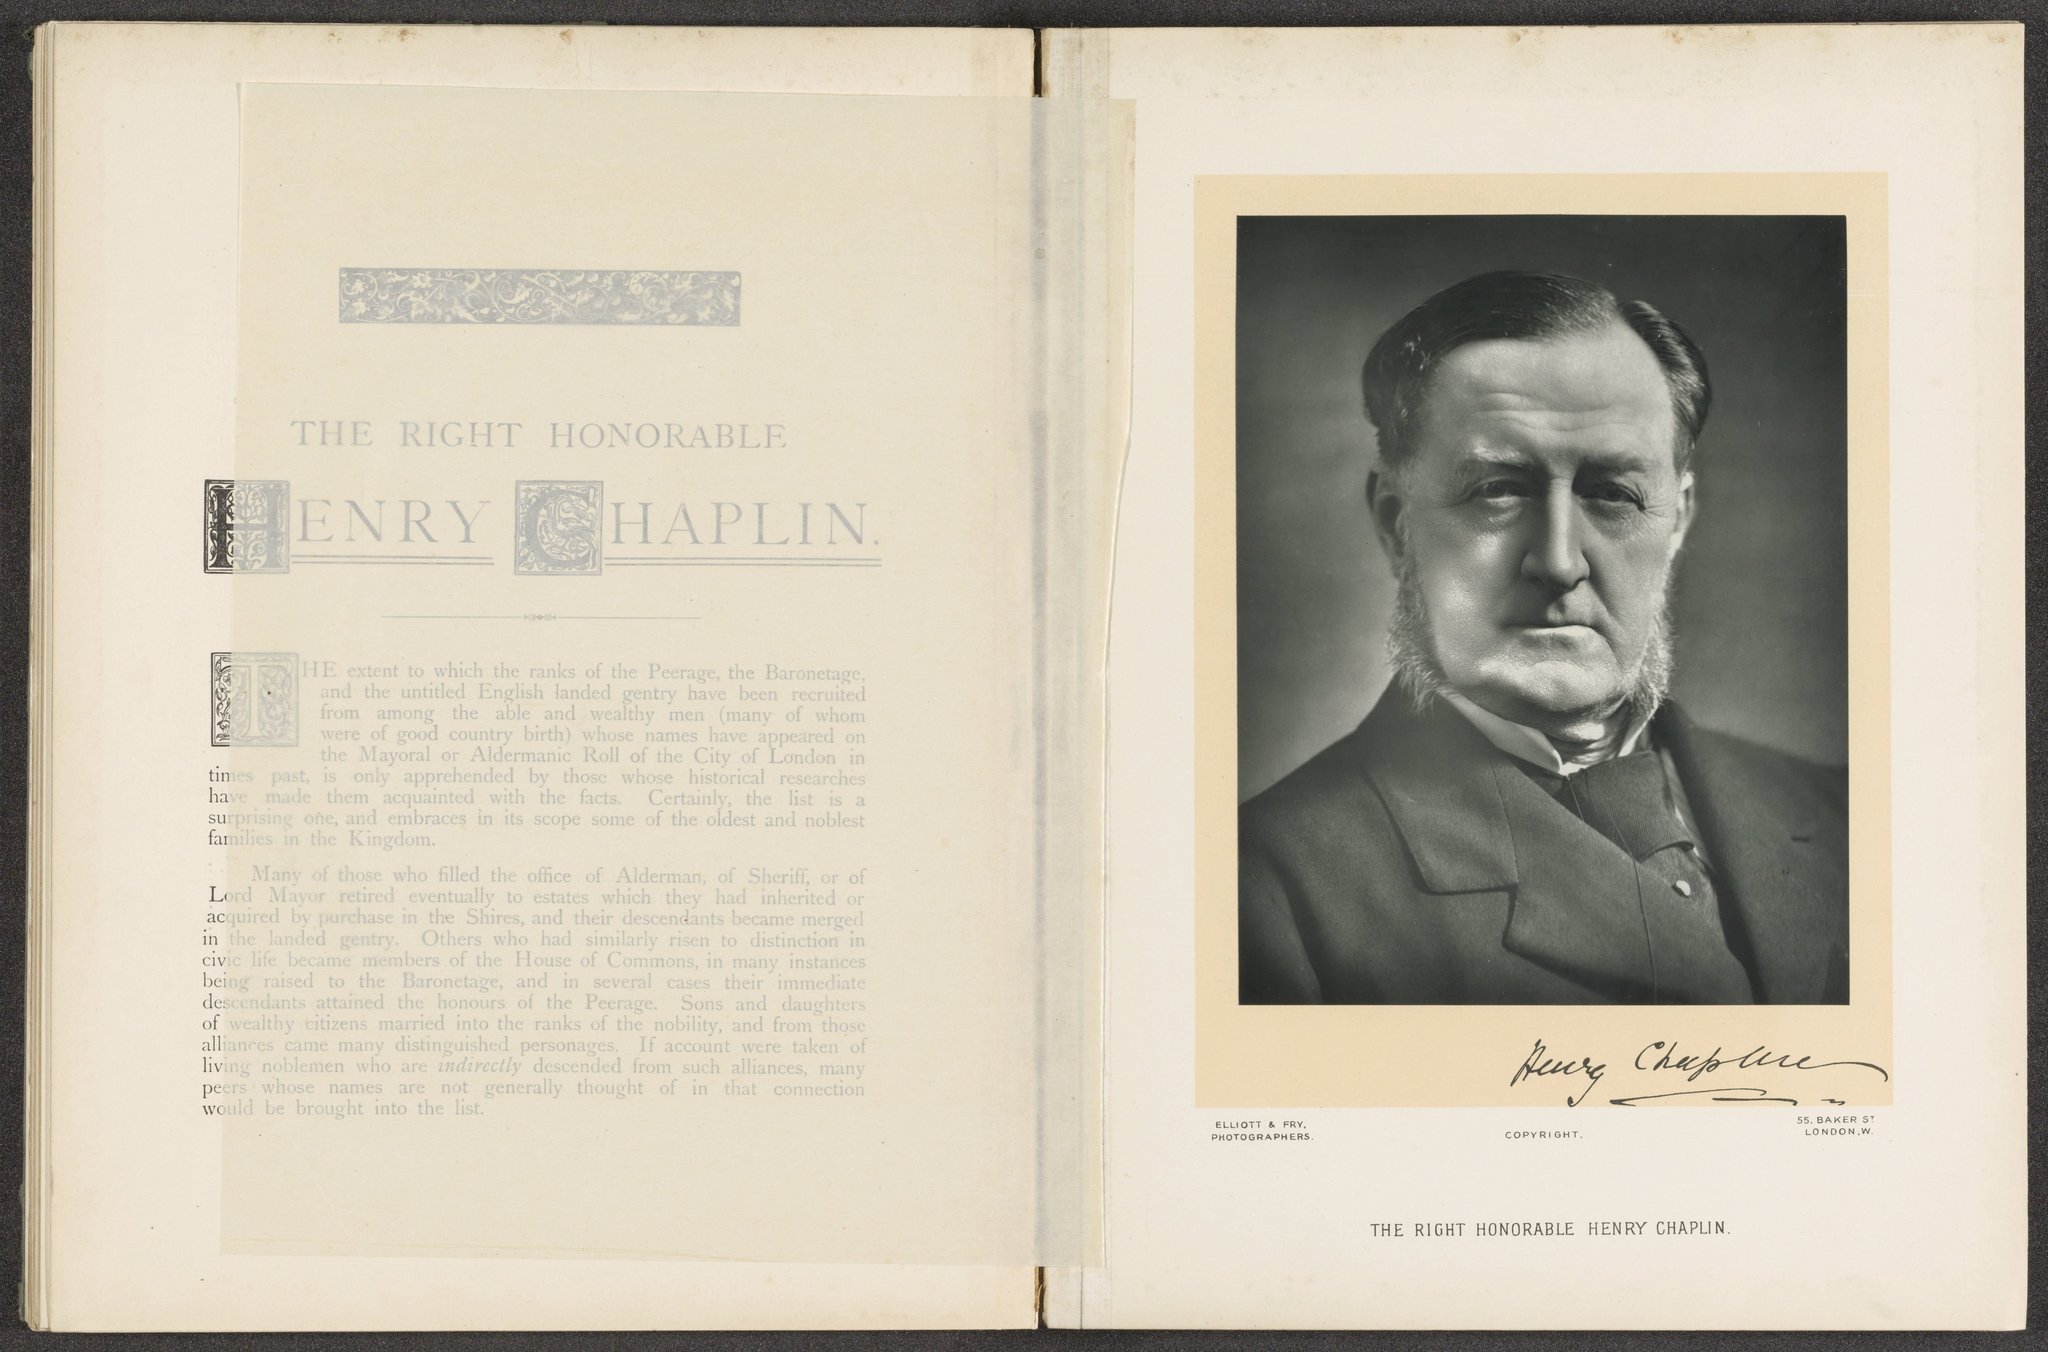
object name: photograph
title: The right honorable Henry Chaplin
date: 1893-1903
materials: paper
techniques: carbon print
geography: london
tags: historical persons (portraits and scenes from the life) (+ (full) bust portrait)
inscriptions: annotation, inscription: ‘55. Baker St. London, W.’